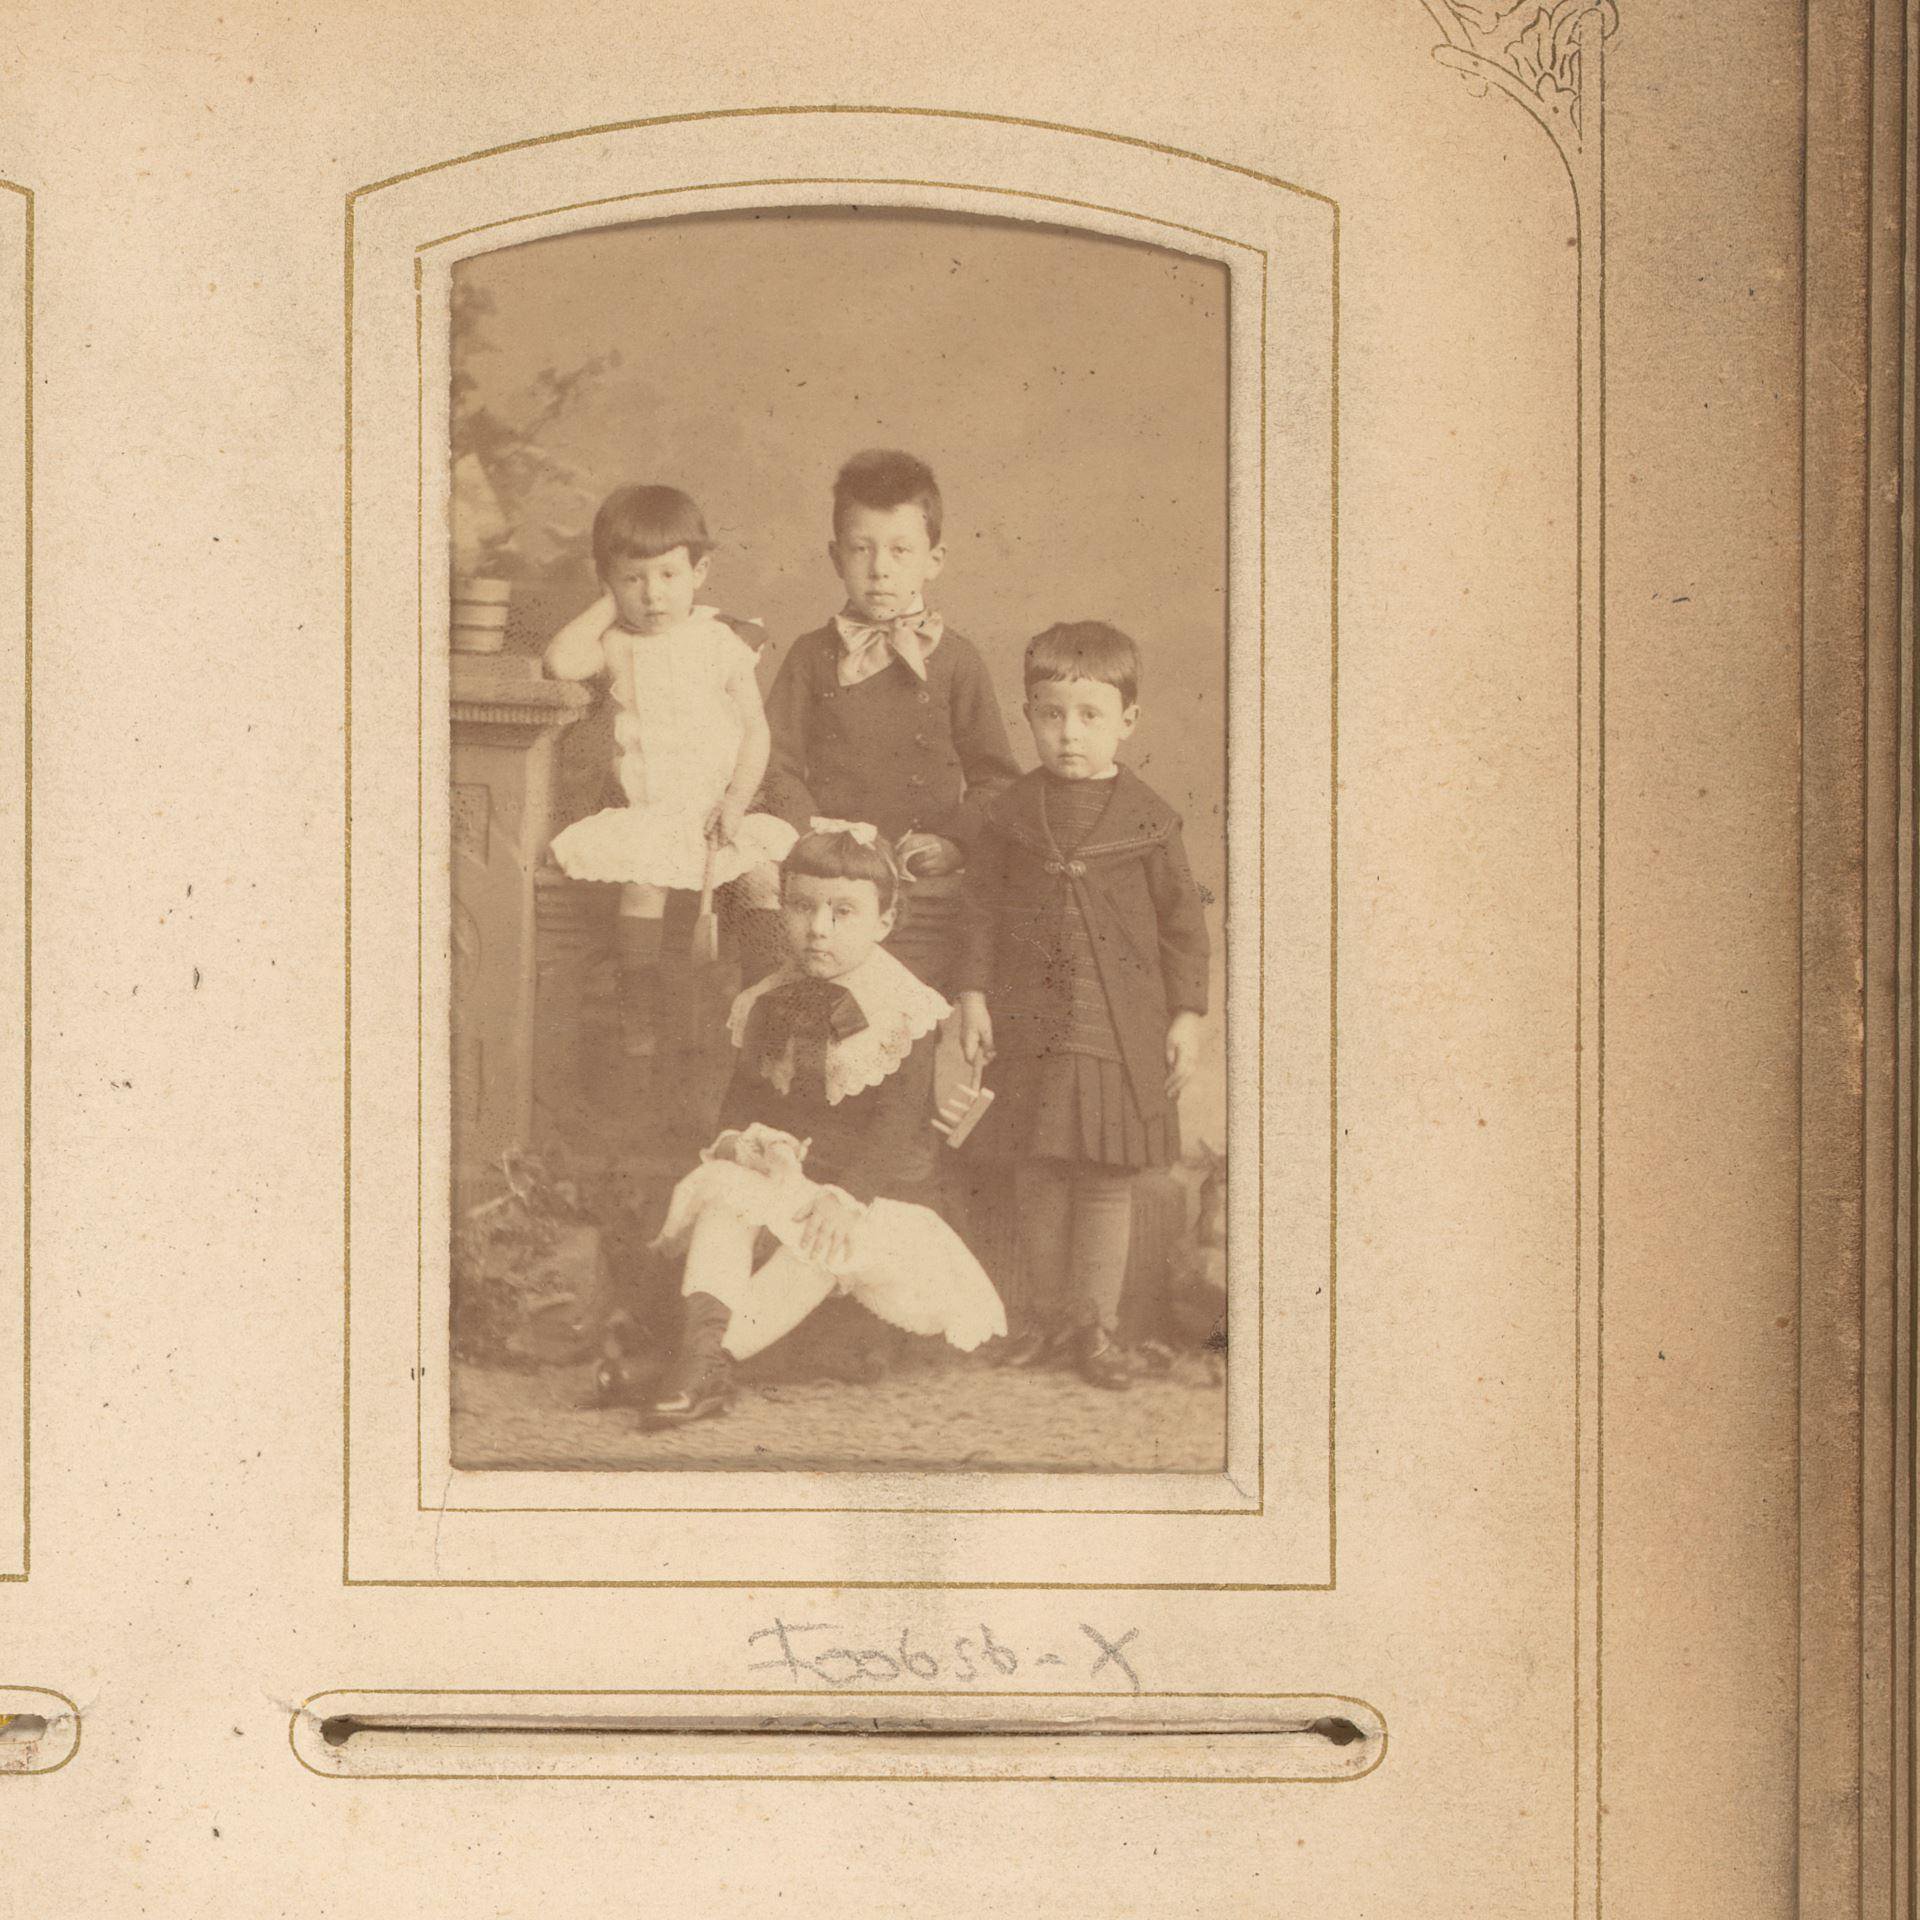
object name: carte de visite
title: Groepsportret van twee jongens en twee meisjes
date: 1875-1899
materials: cardboard, photographic support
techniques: albumen print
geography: amsterdam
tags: boy (child between toddler and youth) (+ two persons), girl (child between toddler and youth), toddler (female), anonymous historical persons portrayed in a group, in a group-portrait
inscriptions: inscription: ‘Photographie Française/ Warmoesstraat 147. Amsterdam.’